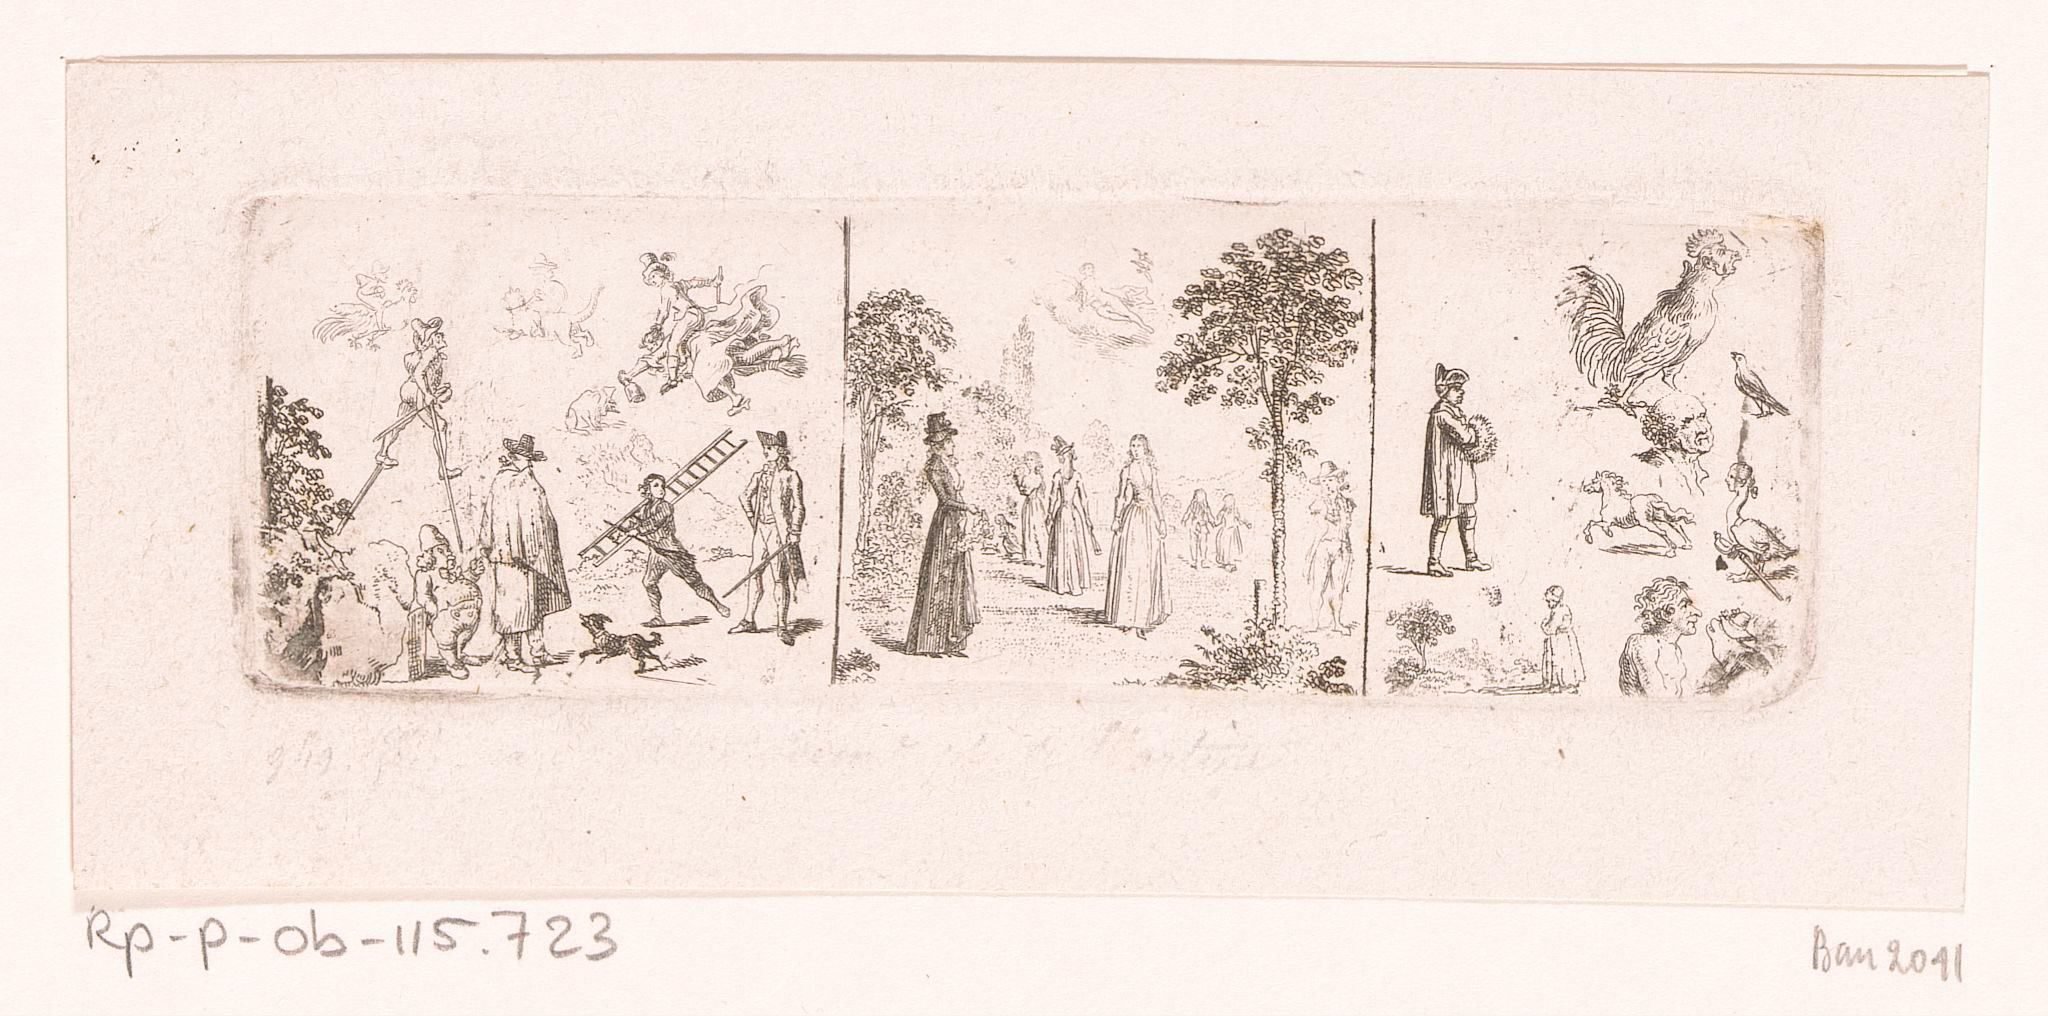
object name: print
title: Verscheidene rariteiten, dames en dieren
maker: daniel nikolaus chodowiecki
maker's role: draughtsman, print maker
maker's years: 1726-1801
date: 1800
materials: paper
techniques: etching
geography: berlin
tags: ornament ~ hybrid beings; human and animal forms mixed, muff, fowl (cock, hen, chicken, etc.), flying on broomstick, pitchfork, trident ~ witches' sabbath, ladder, fashion, (walking on) stilts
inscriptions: collector's mark: Lugt 2228